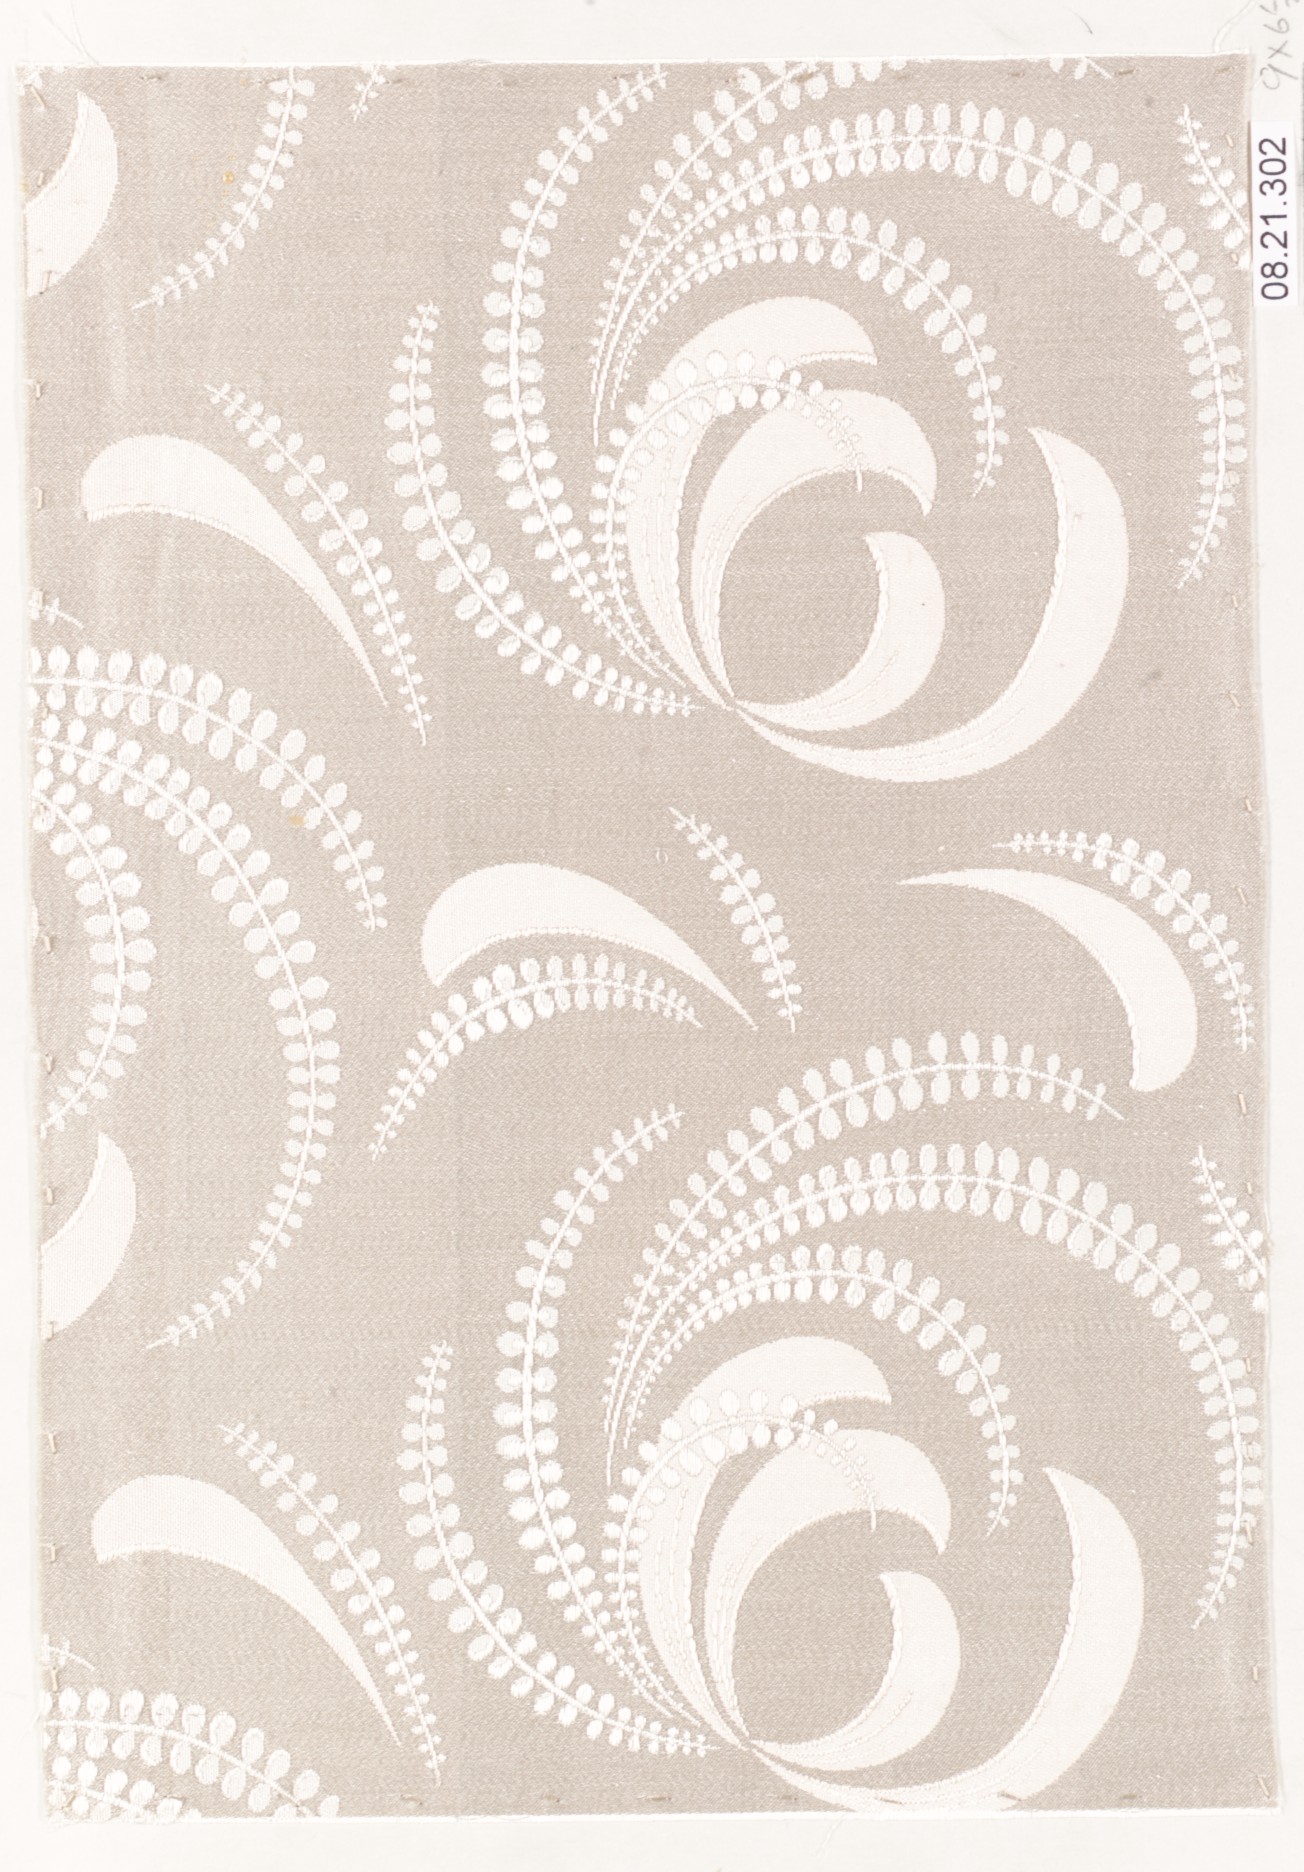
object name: textile sample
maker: Anonymous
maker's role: designer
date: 1900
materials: silk